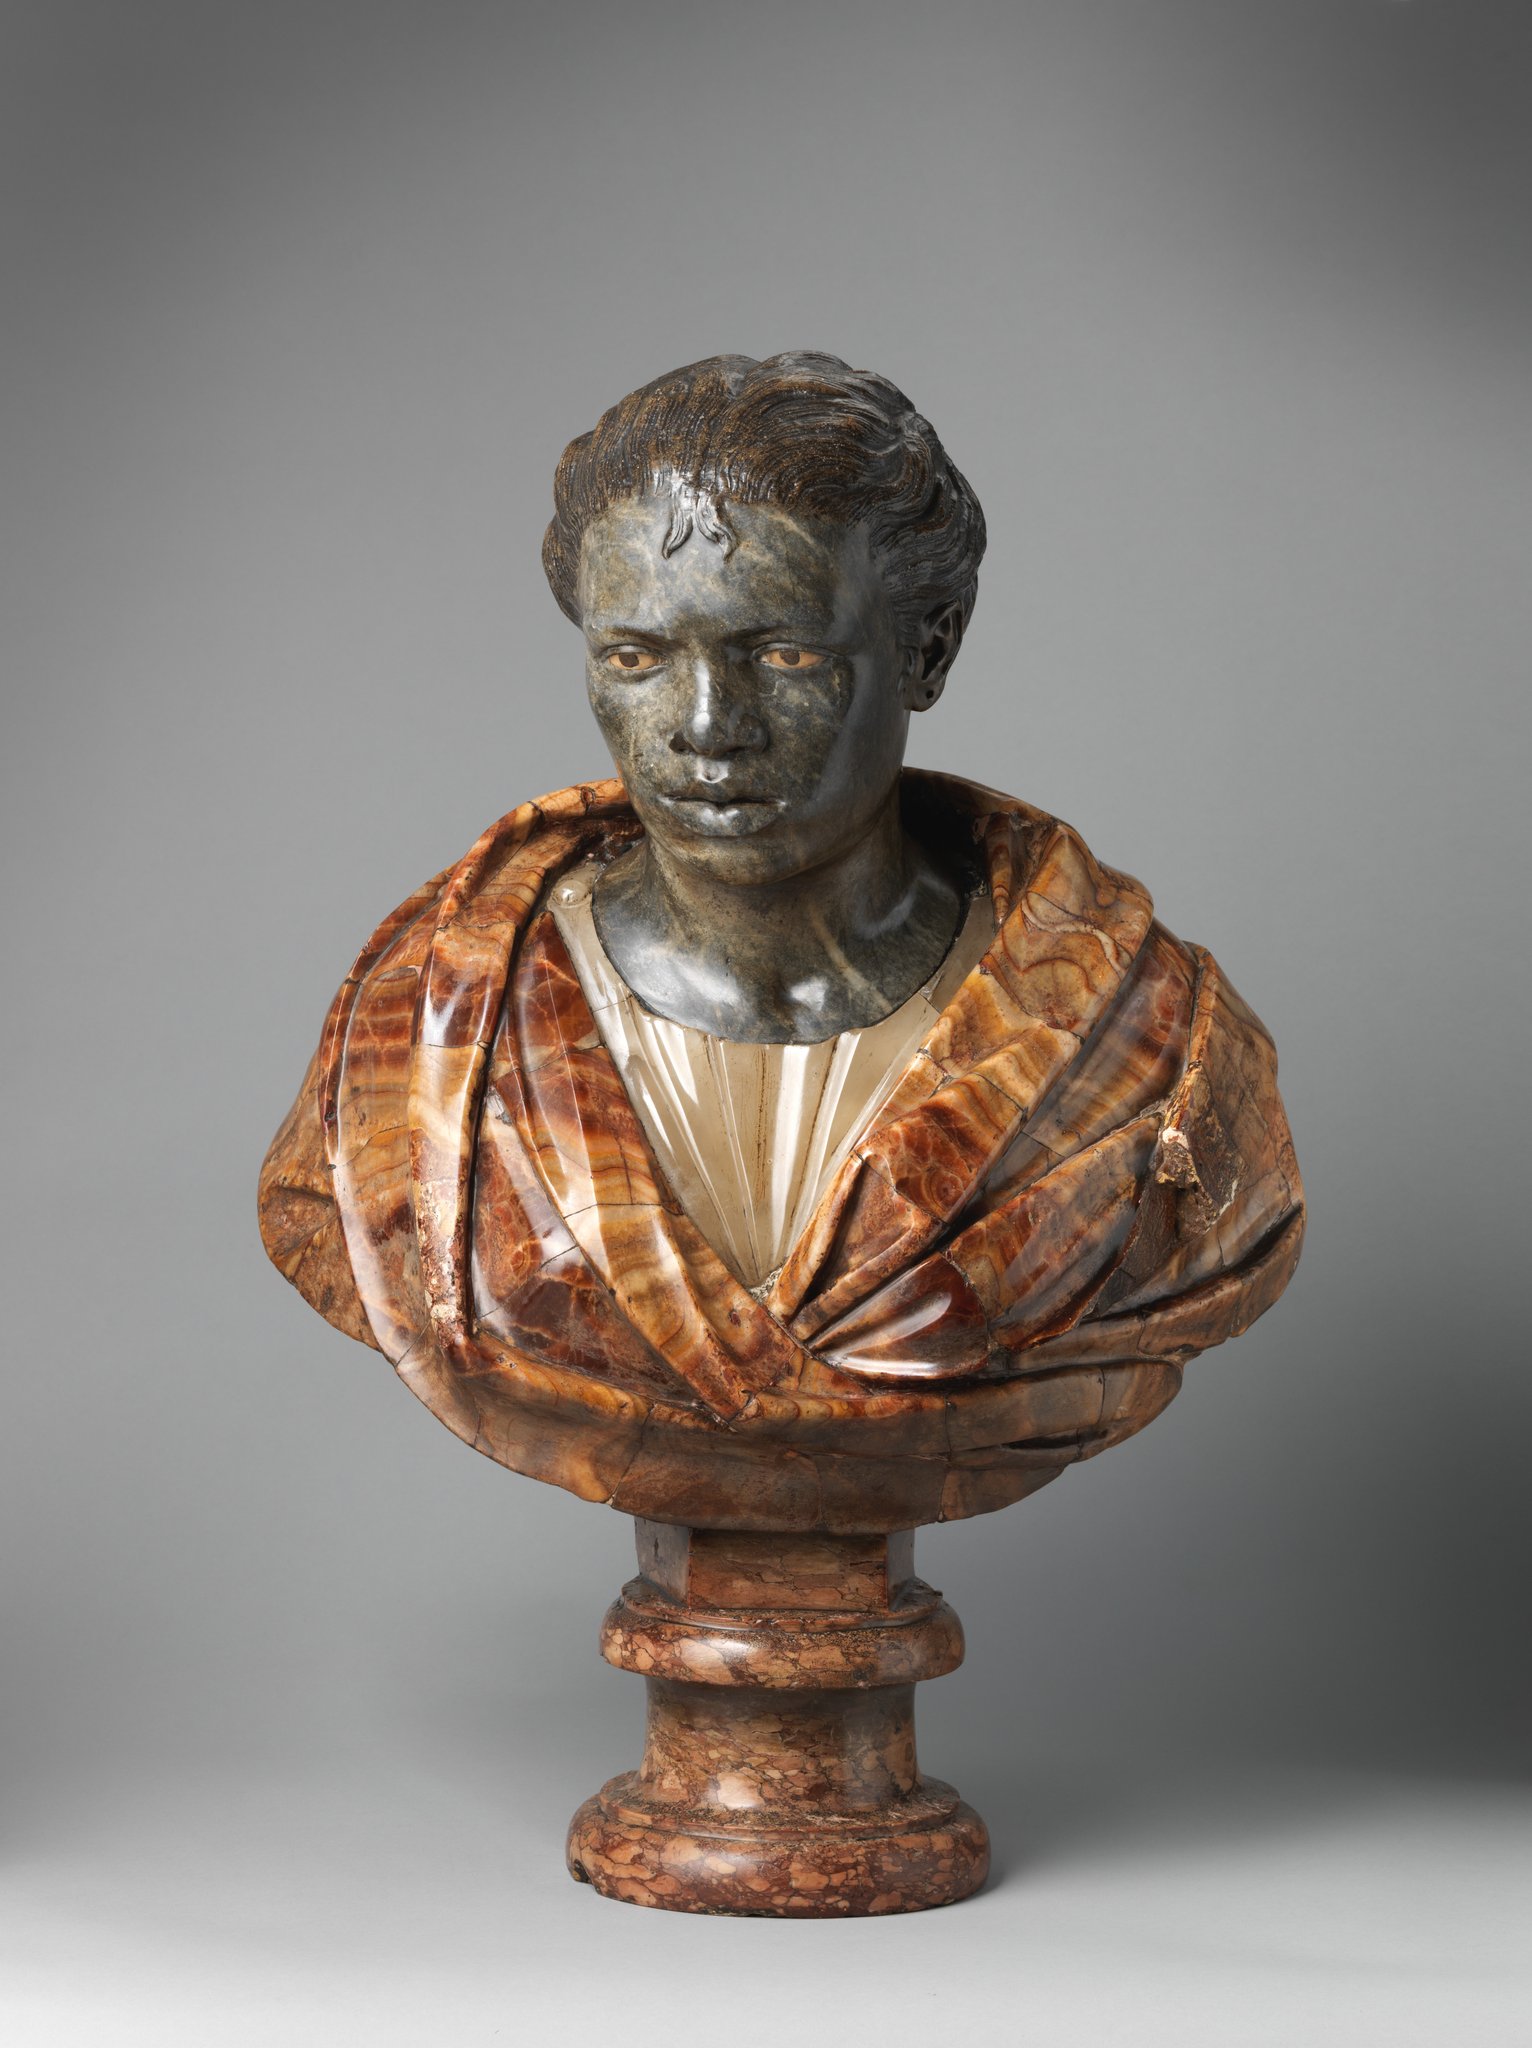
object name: bust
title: Bust of a Woman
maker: nicolas cordier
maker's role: artist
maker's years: 1567-1612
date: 1701-1800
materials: marble